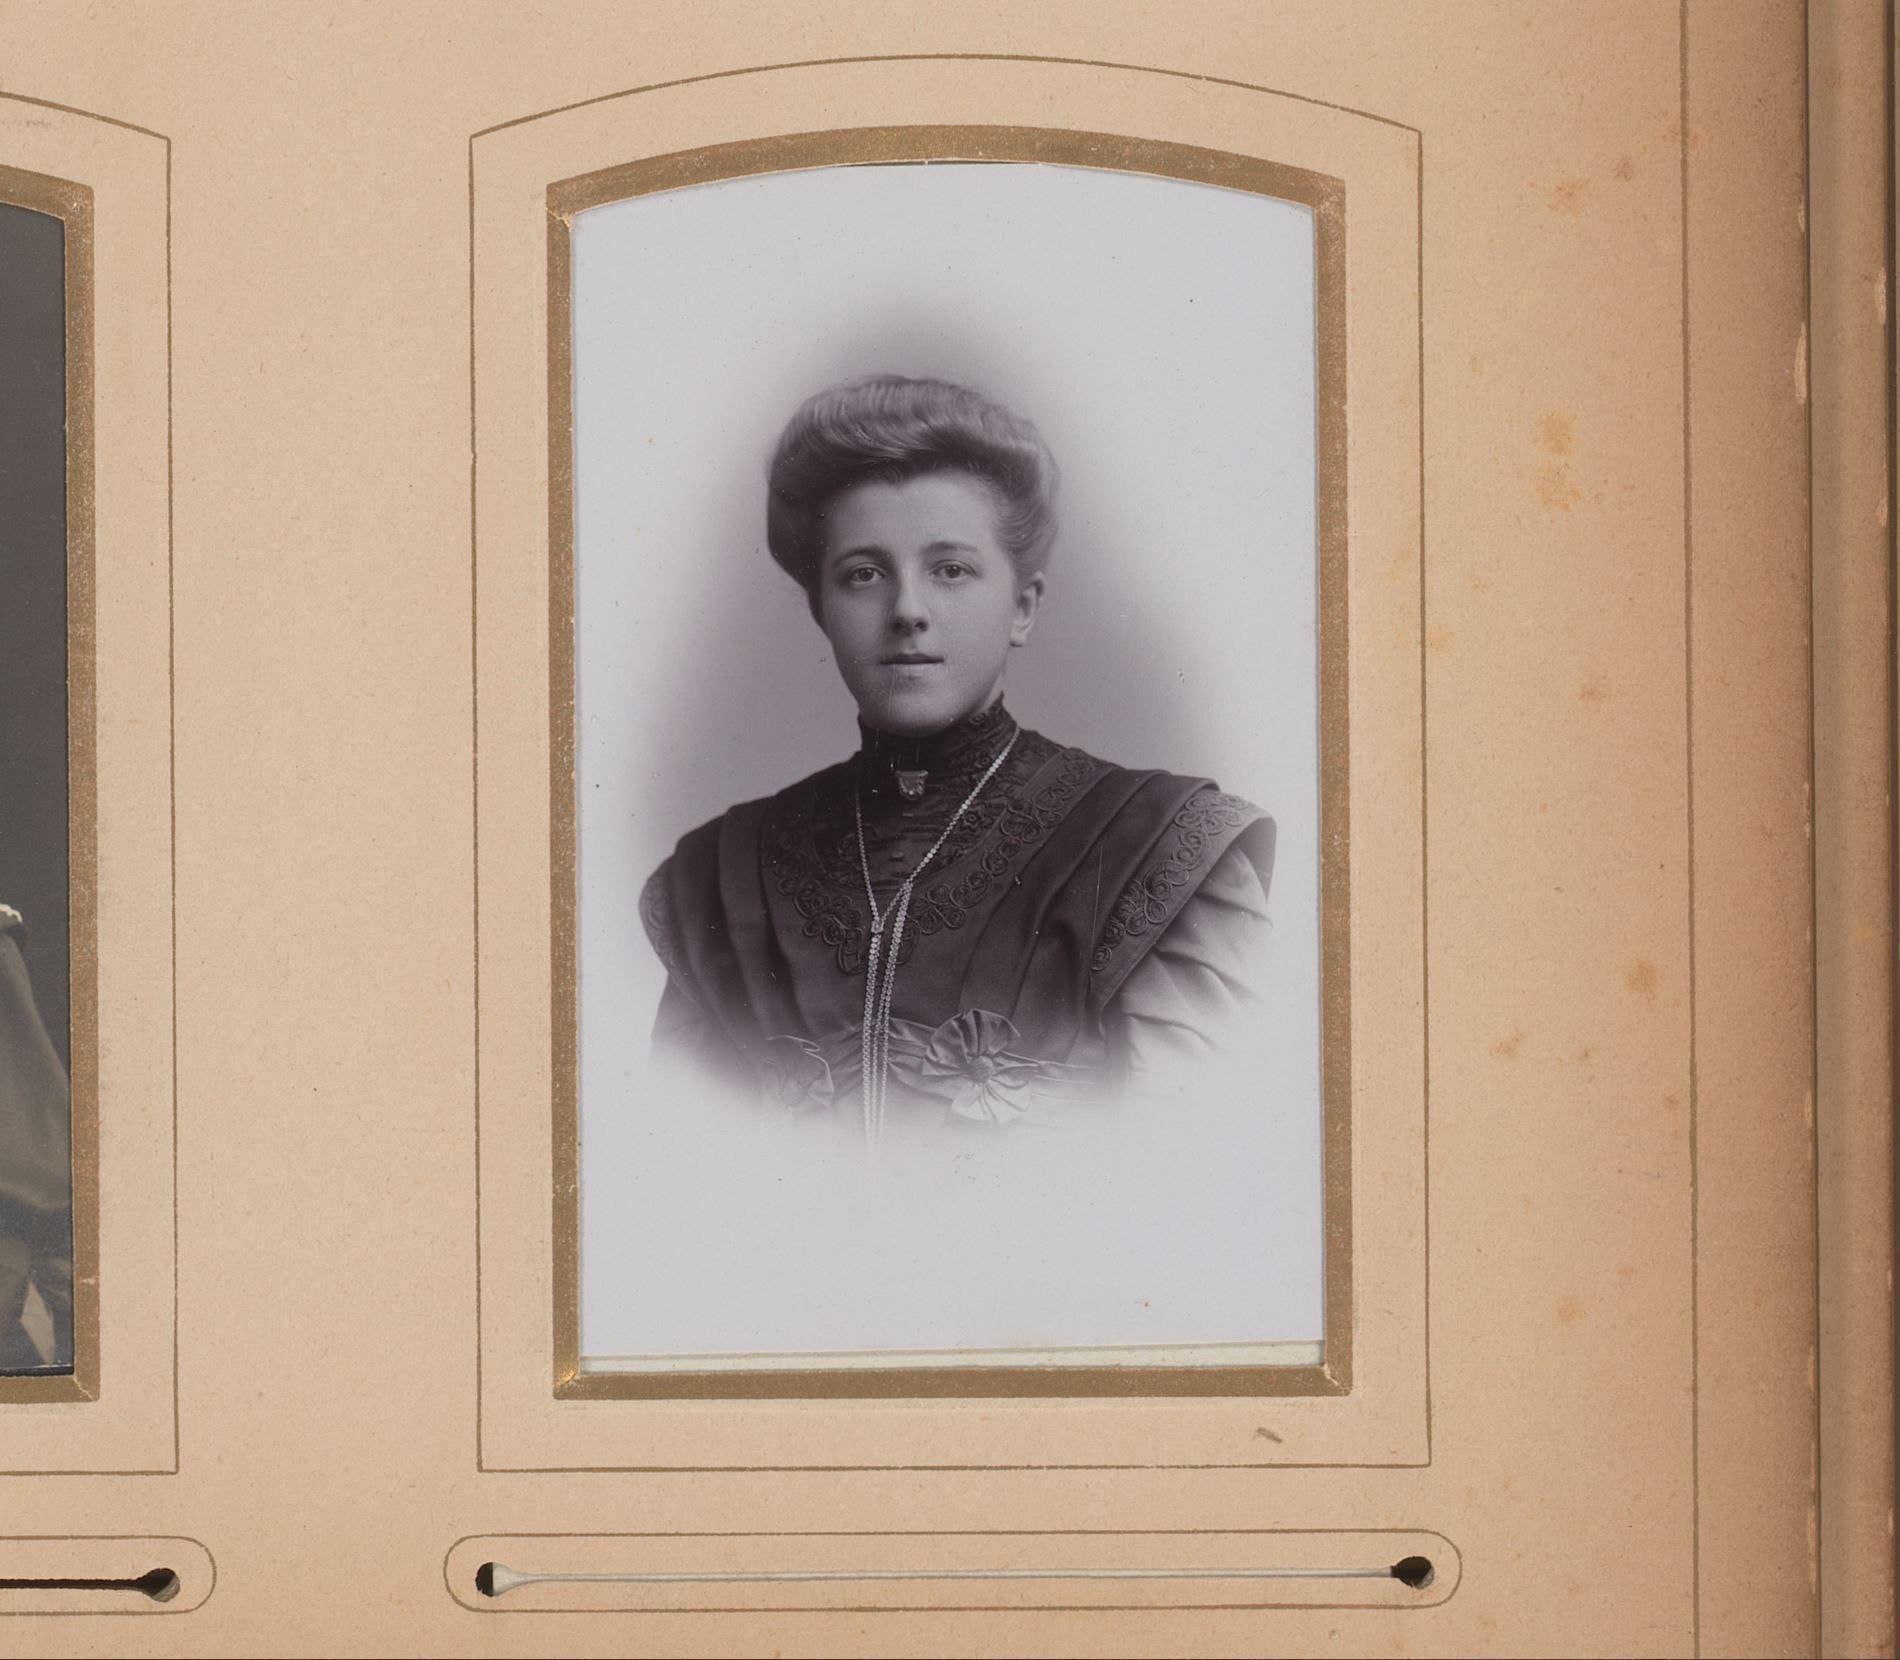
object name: photograph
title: Portret van een jonge vrouw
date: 1885-1906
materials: cardboard, photographic support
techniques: collodion silver print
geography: amsterdam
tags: adolescent, young woman, maiden, historical persons - bb - woman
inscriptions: inscription: ‘W.G. Kuijer en Zonen/ Hofphotographen/ Amsterdam/ Westermarkt 19./ Speciale Inrichting/ voor/ Vergrootingen in alle Formaten.’